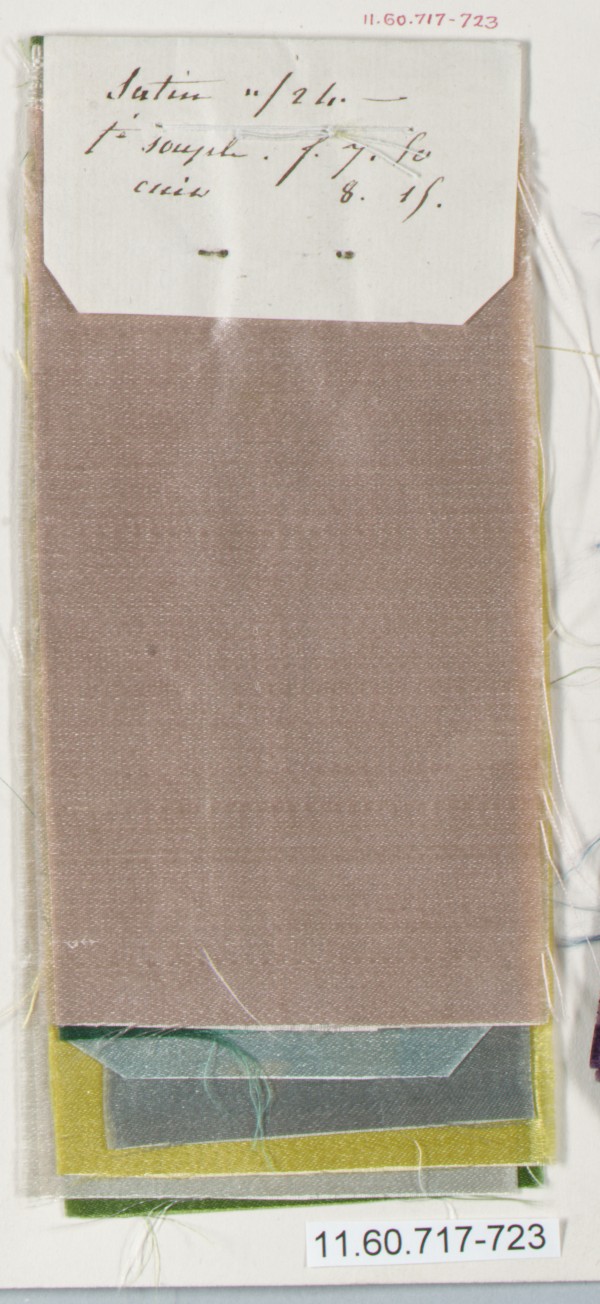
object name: sample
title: Samples (7)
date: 1801-1850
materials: silk